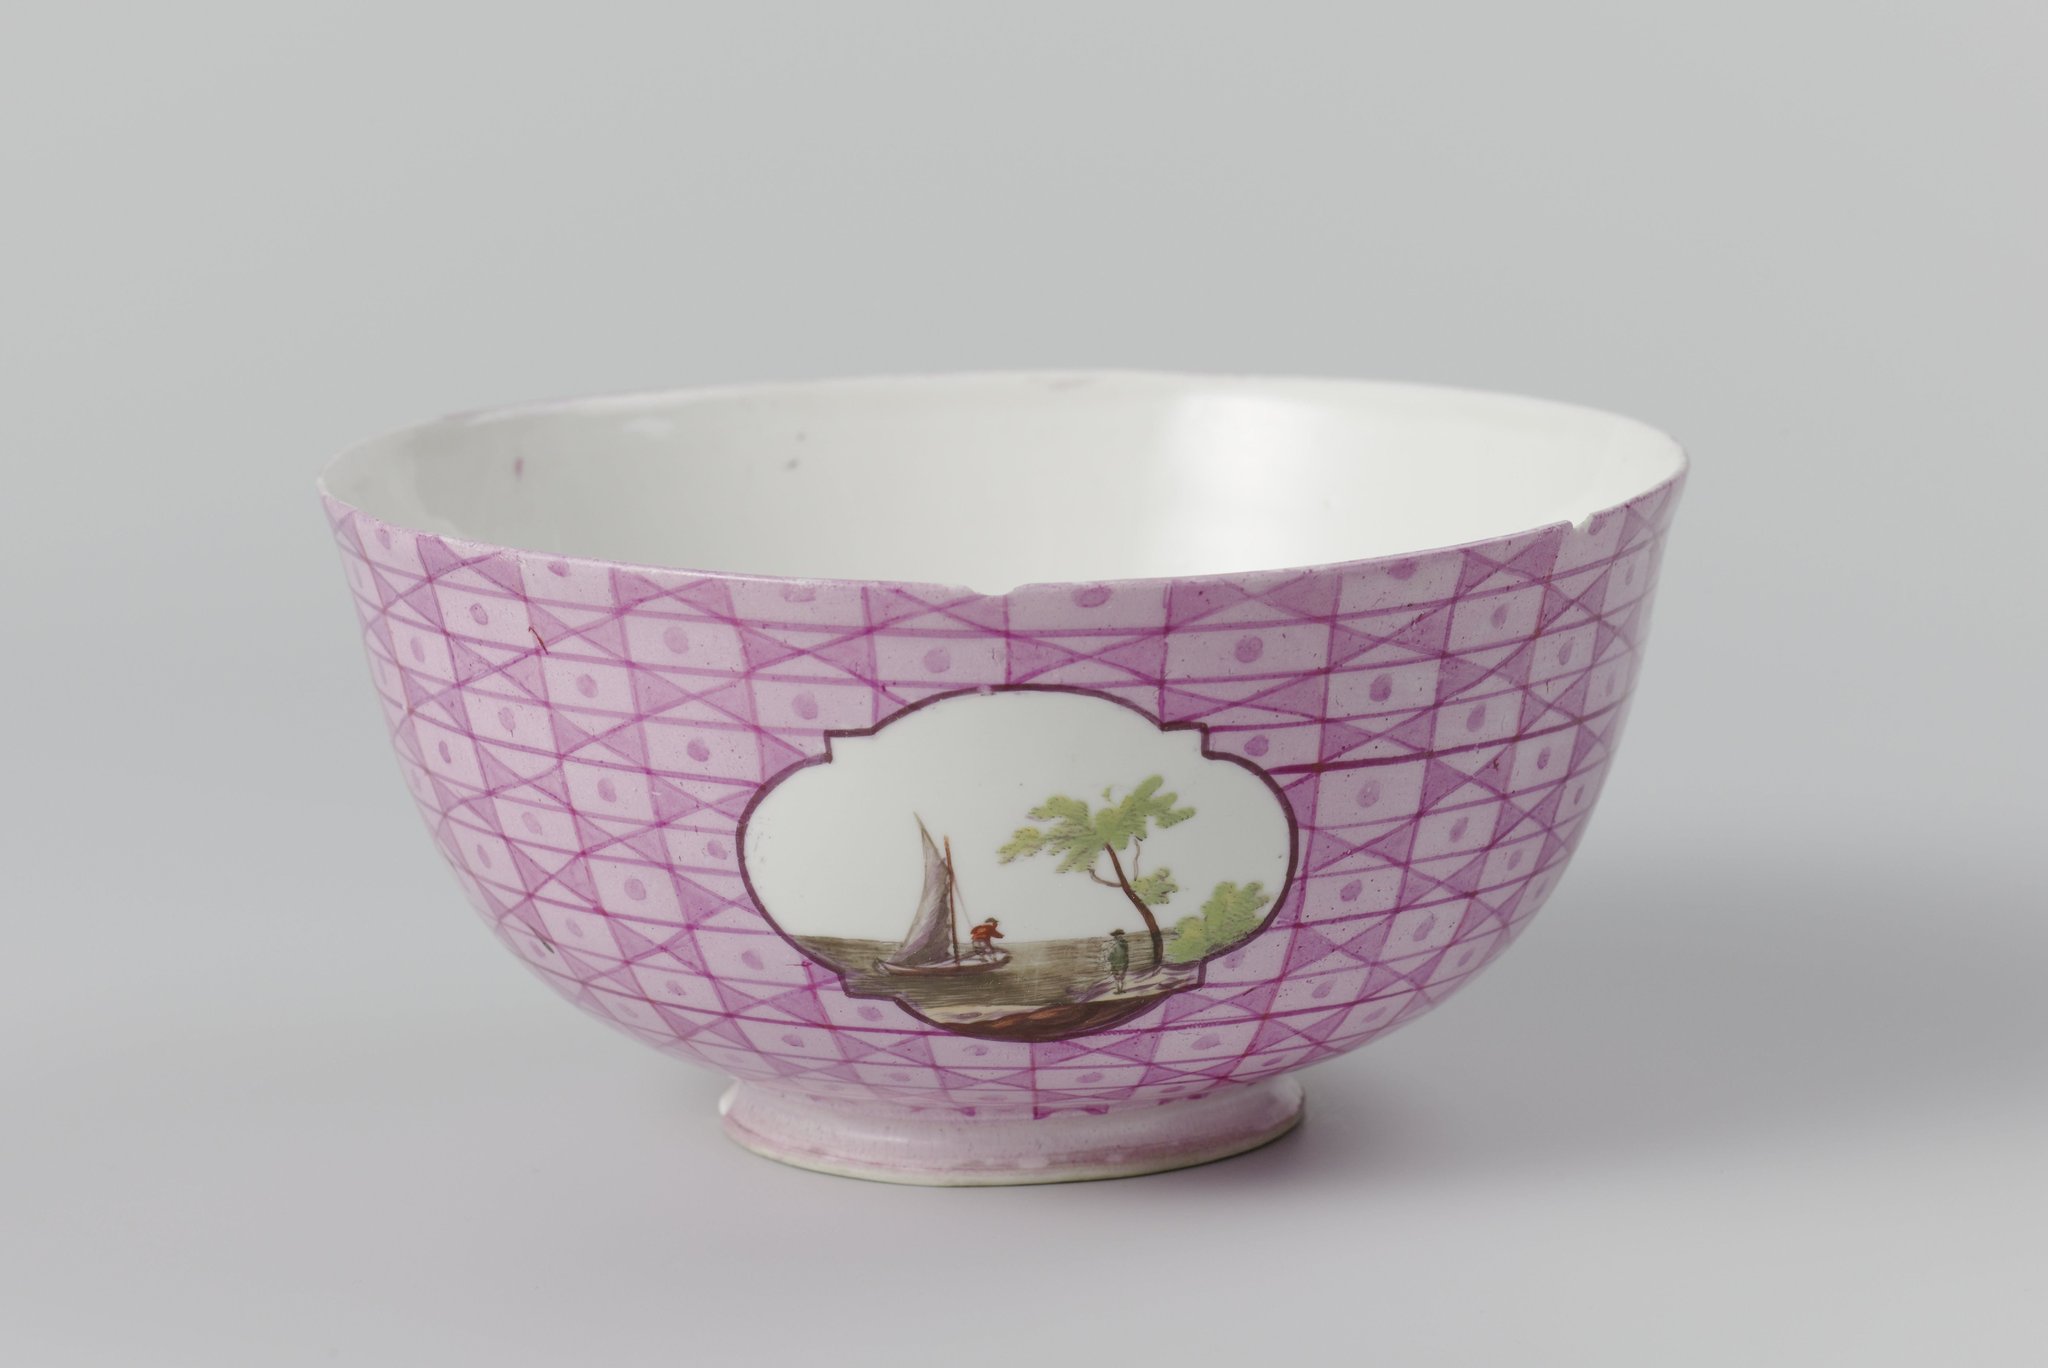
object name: slop bowl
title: Spoelkom, polychroom beschilderd met een landschap in een medaillon uitgespaard in een geometirsch patroon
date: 1759-1771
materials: porcelain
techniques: painted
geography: weesp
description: Spoelkom met een veelkleurig landschap in een medaillon uitgespaard in een paars geometrisch patroon.